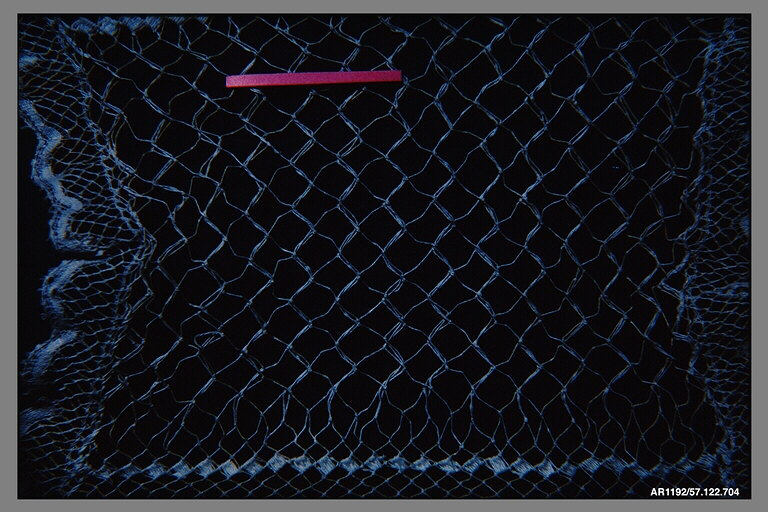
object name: sampler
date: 1801-1900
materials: cotton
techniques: embroidery